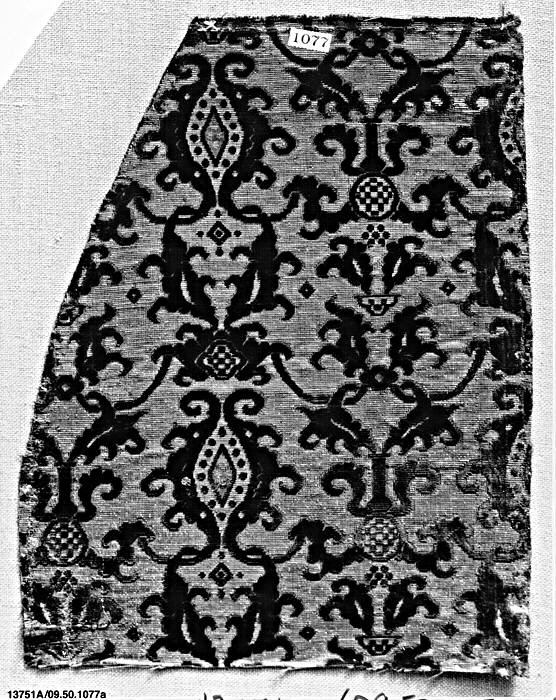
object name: piece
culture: chinese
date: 1801-1900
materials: silk